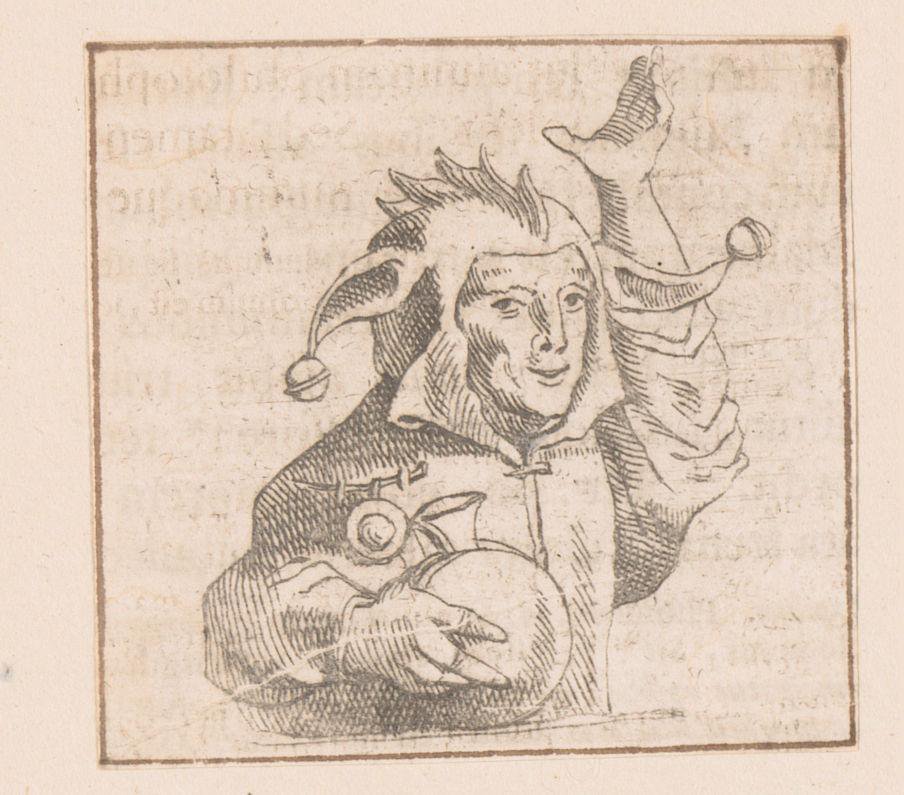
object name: print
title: Illustraties uit de Lof der Zotheid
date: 1516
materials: paper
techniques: etching, letterpress printing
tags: desiderius erasmus, court jester, court fool, folly, foolishness; 'pazzia', 'sciocchezza', 'stoltitia' (ripa)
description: Prent afkomstig uit: Erasmus, Desiderius. Morias enkomion (...). Bazel: Johann Rudolf Genath, 1676. De prenten hierin zijn naar tekeningen die Hans en Ambrosius Holbein maakten voor de theoloog Oswald Myconius in diens uitgave van de Moriae encomium (Lof der Zotheid) van 1516.